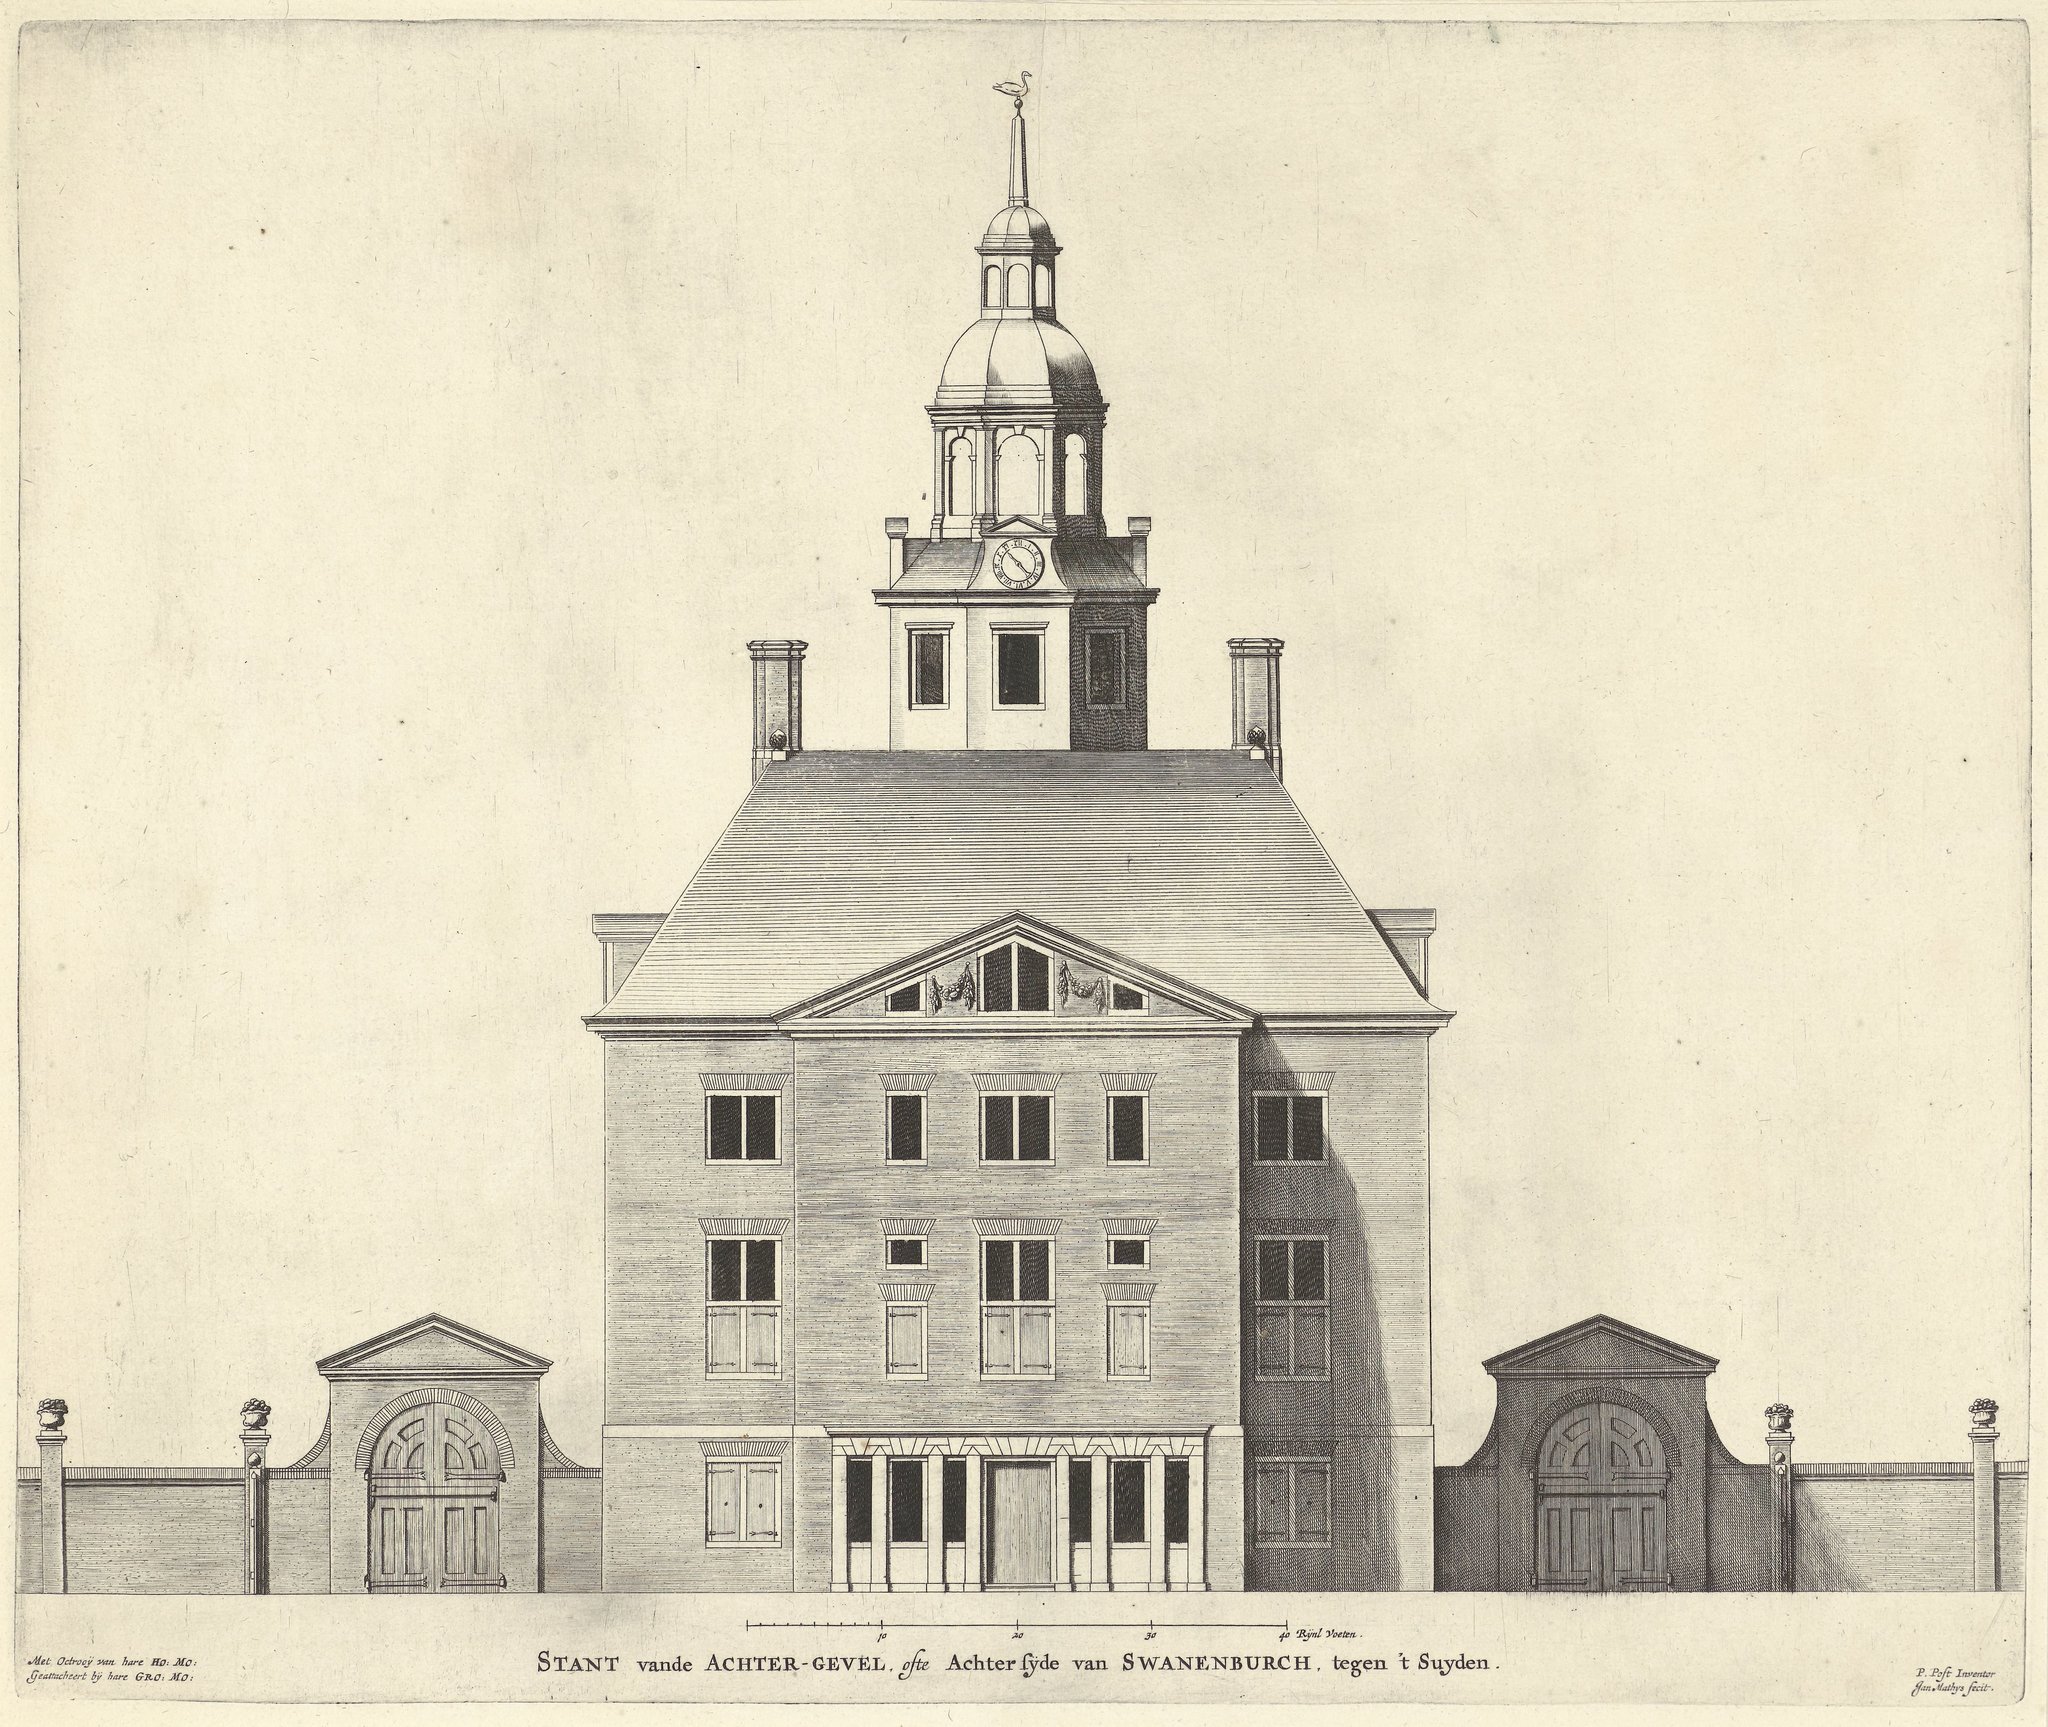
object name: print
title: Swanenburg, gemeenlandshuis van Rijnland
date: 1654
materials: paper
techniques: engraving, etching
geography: amsterdam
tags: exterior ~ architectural design or model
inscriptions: collector's mark: Lugt 2228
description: Achterzijde van Swanenburg, het gemeenlandshuis van het hoogheemraadschap van Rijnland, te Halfweg. Links en rechts een toegangspoort.